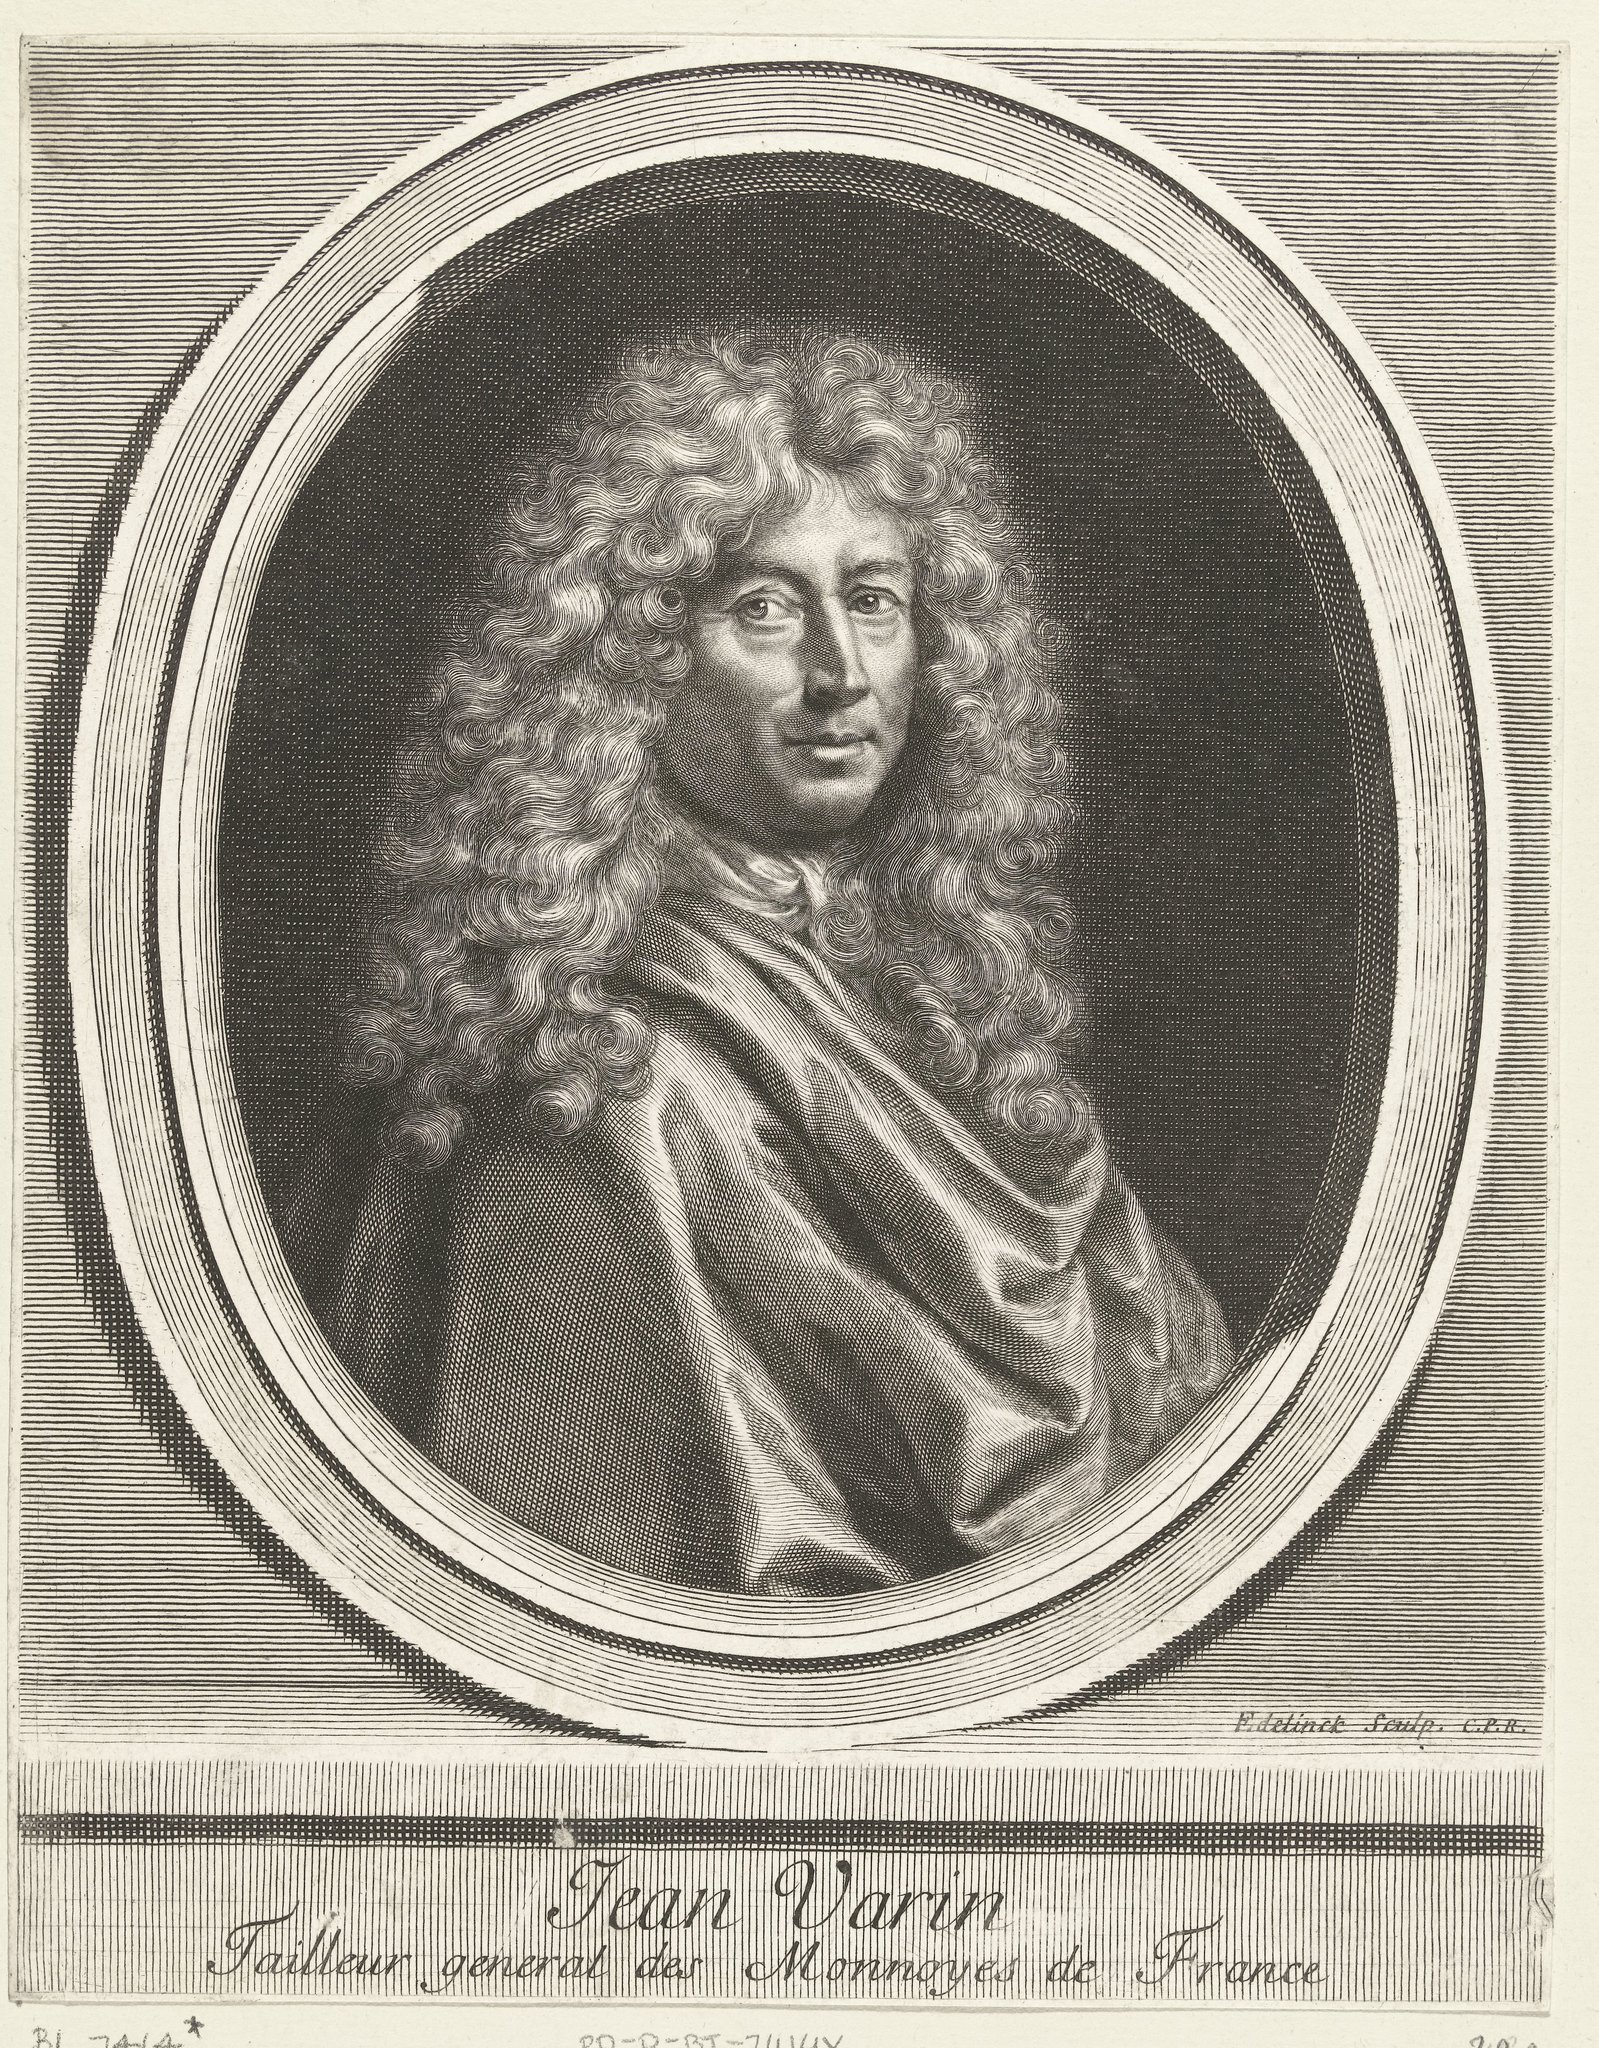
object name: print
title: Portret van Jean Varin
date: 1700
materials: paper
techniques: engraving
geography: france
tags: print maker, jean varin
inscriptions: collector's mark: Lugt 240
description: Prent waarschijnlijk uit: Perrault, Charles. Les Hommes illustres qui ont paru en France pendant ce Siècle (...). Parijs: Antoine Dazallier, 1700, dl. 2.